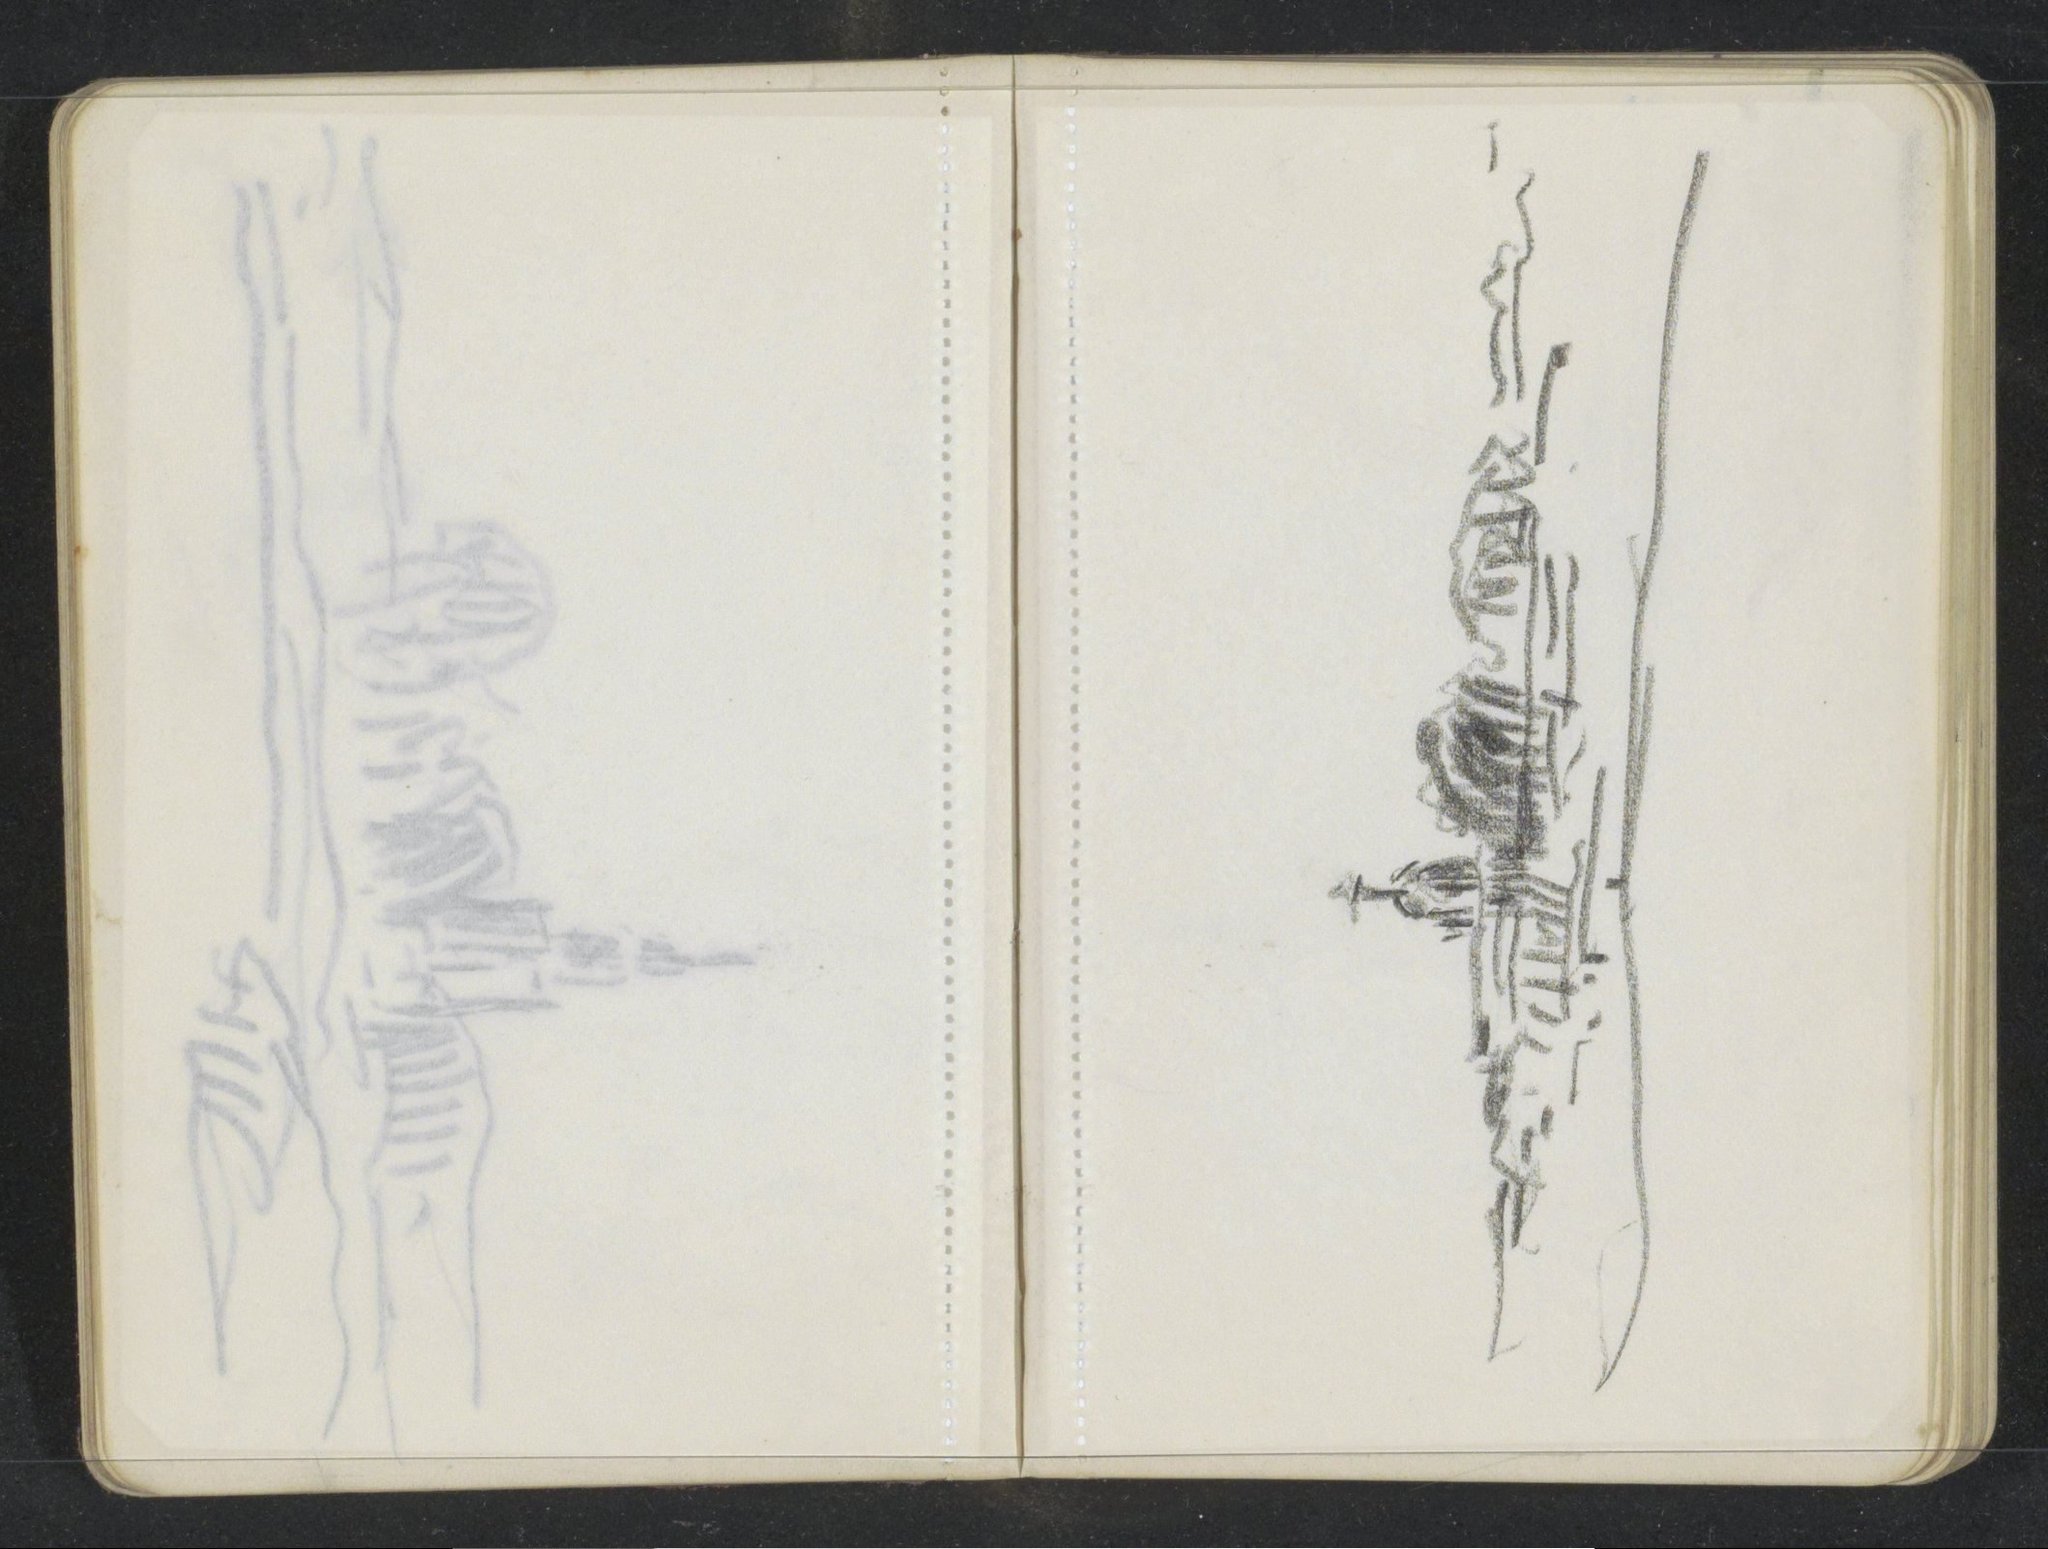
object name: sketchbook leaf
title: Landschap met koepelkerk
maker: alexander shilling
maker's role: draughtsman, print maker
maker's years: 1859-1937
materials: chalk, paper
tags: city-view, and landscape with man-made constructions, parts of church exterior and annexes: dome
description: Blad 14 recto uit een schetsboek met 91 bladen.